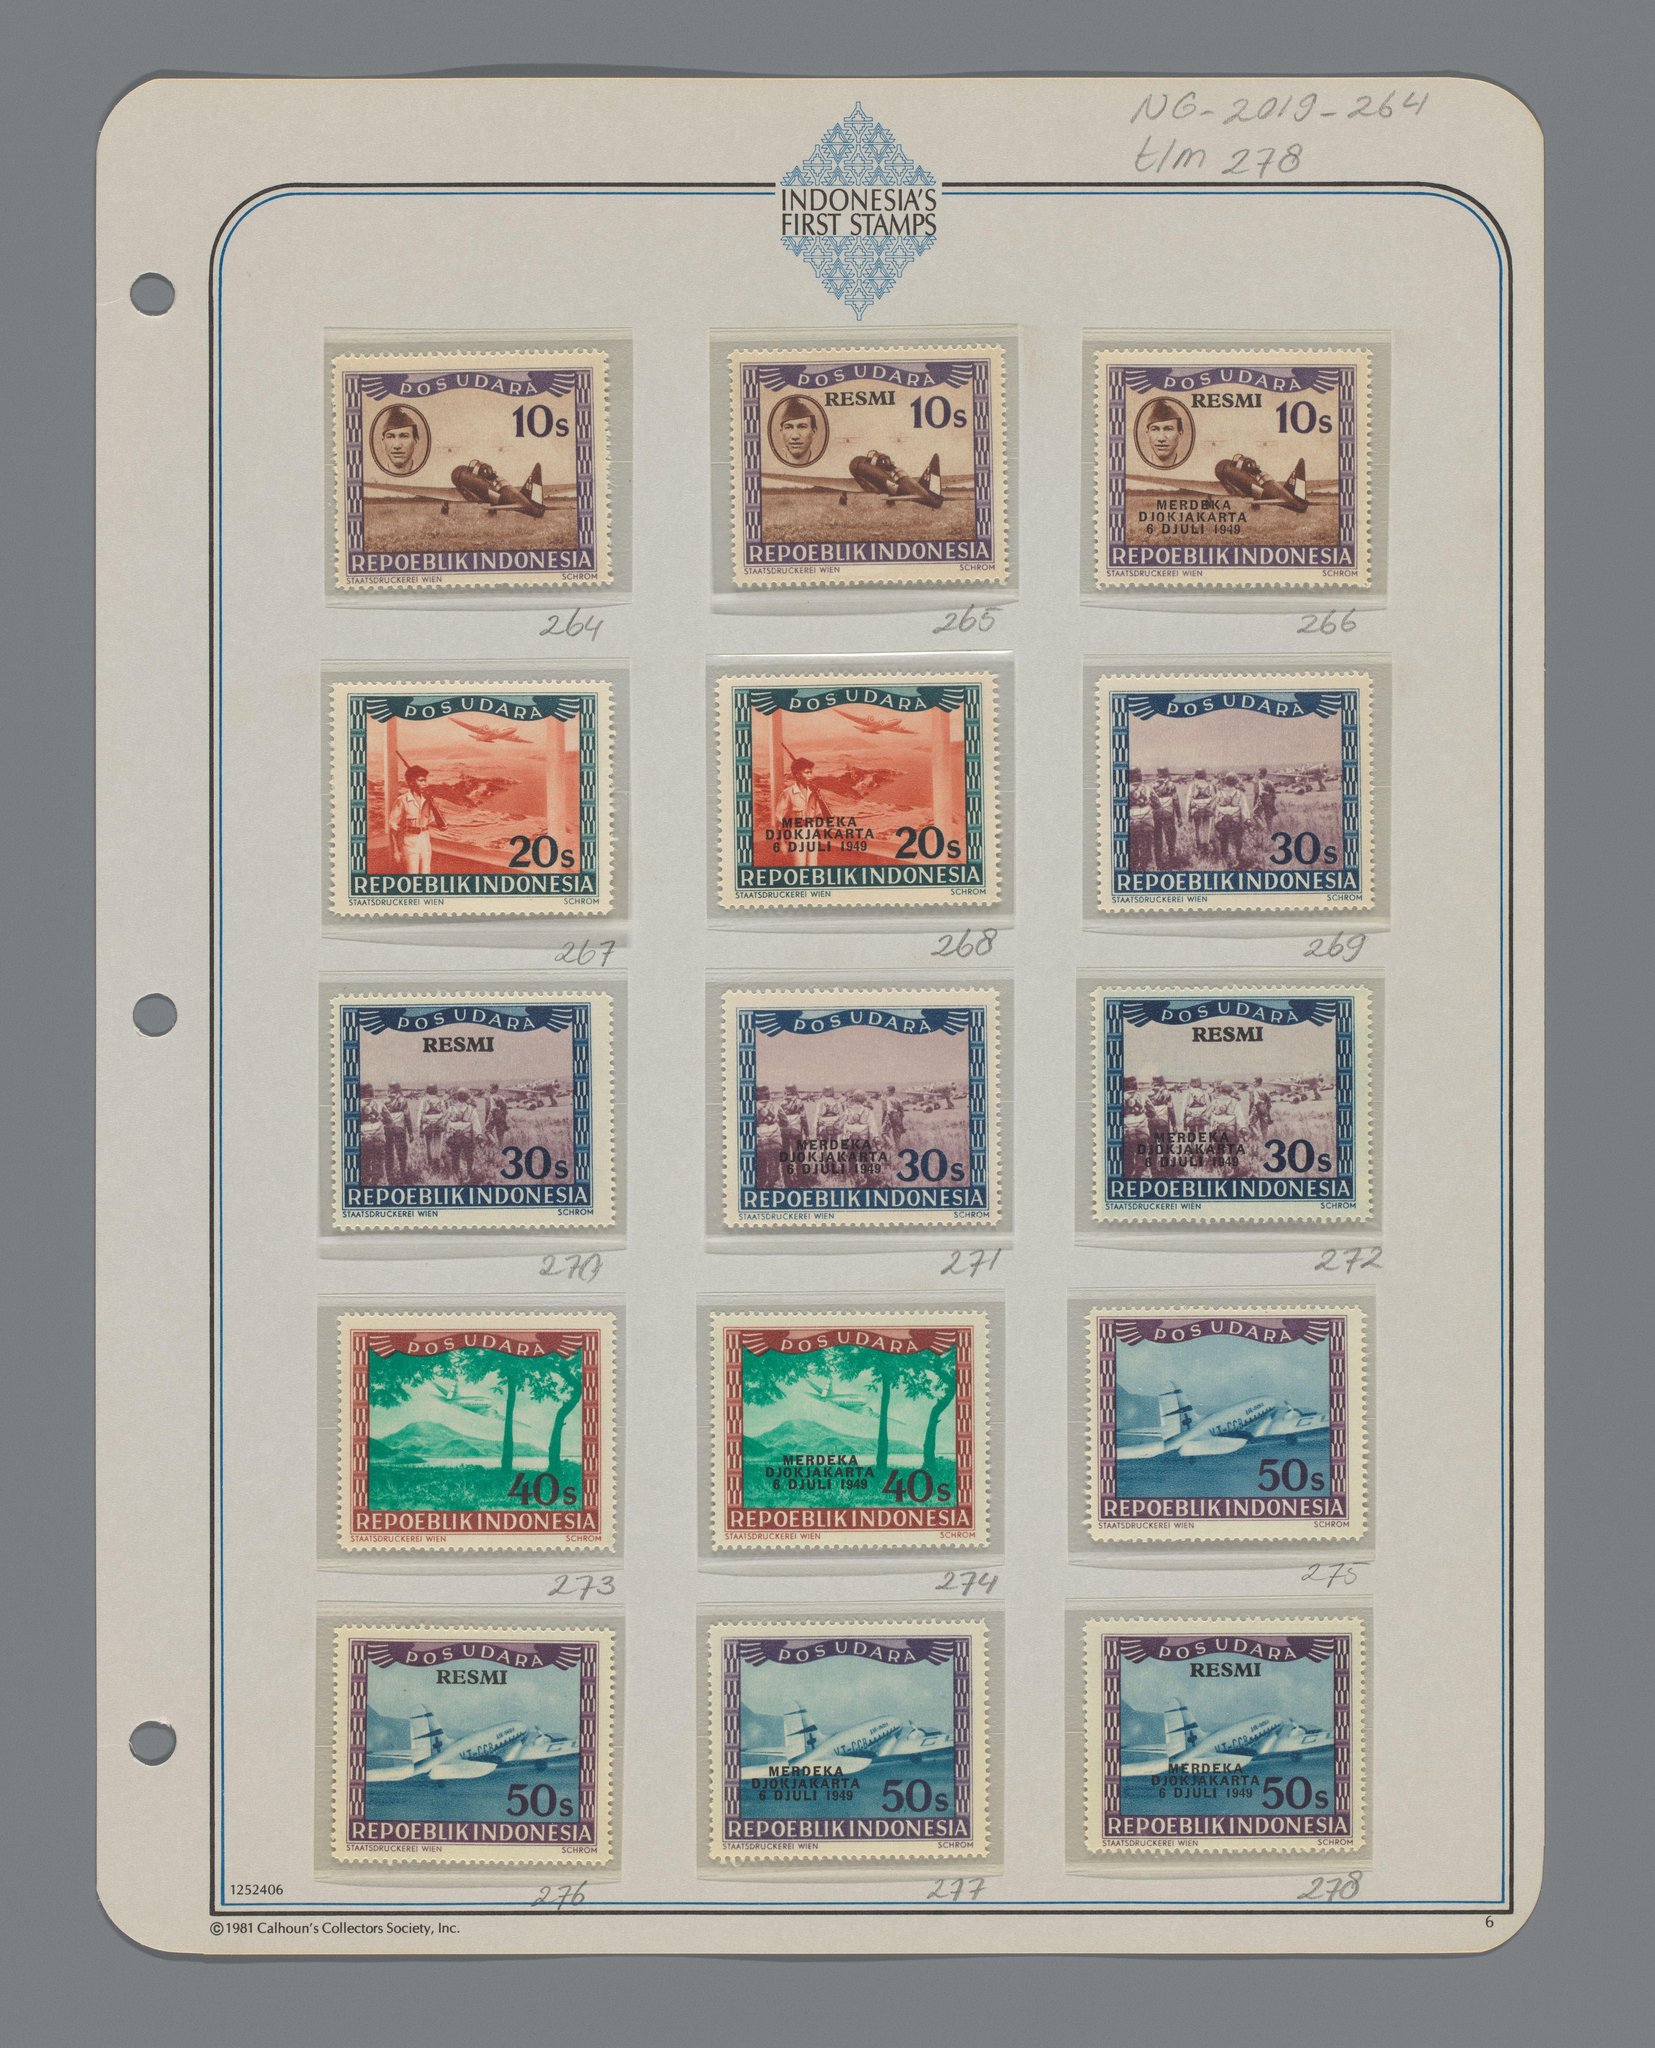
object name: postage stamp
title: Postzegel Republik Indonesia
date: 1949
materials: paper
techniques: photoaquatint, engraving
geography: philadelphia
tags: indonesia